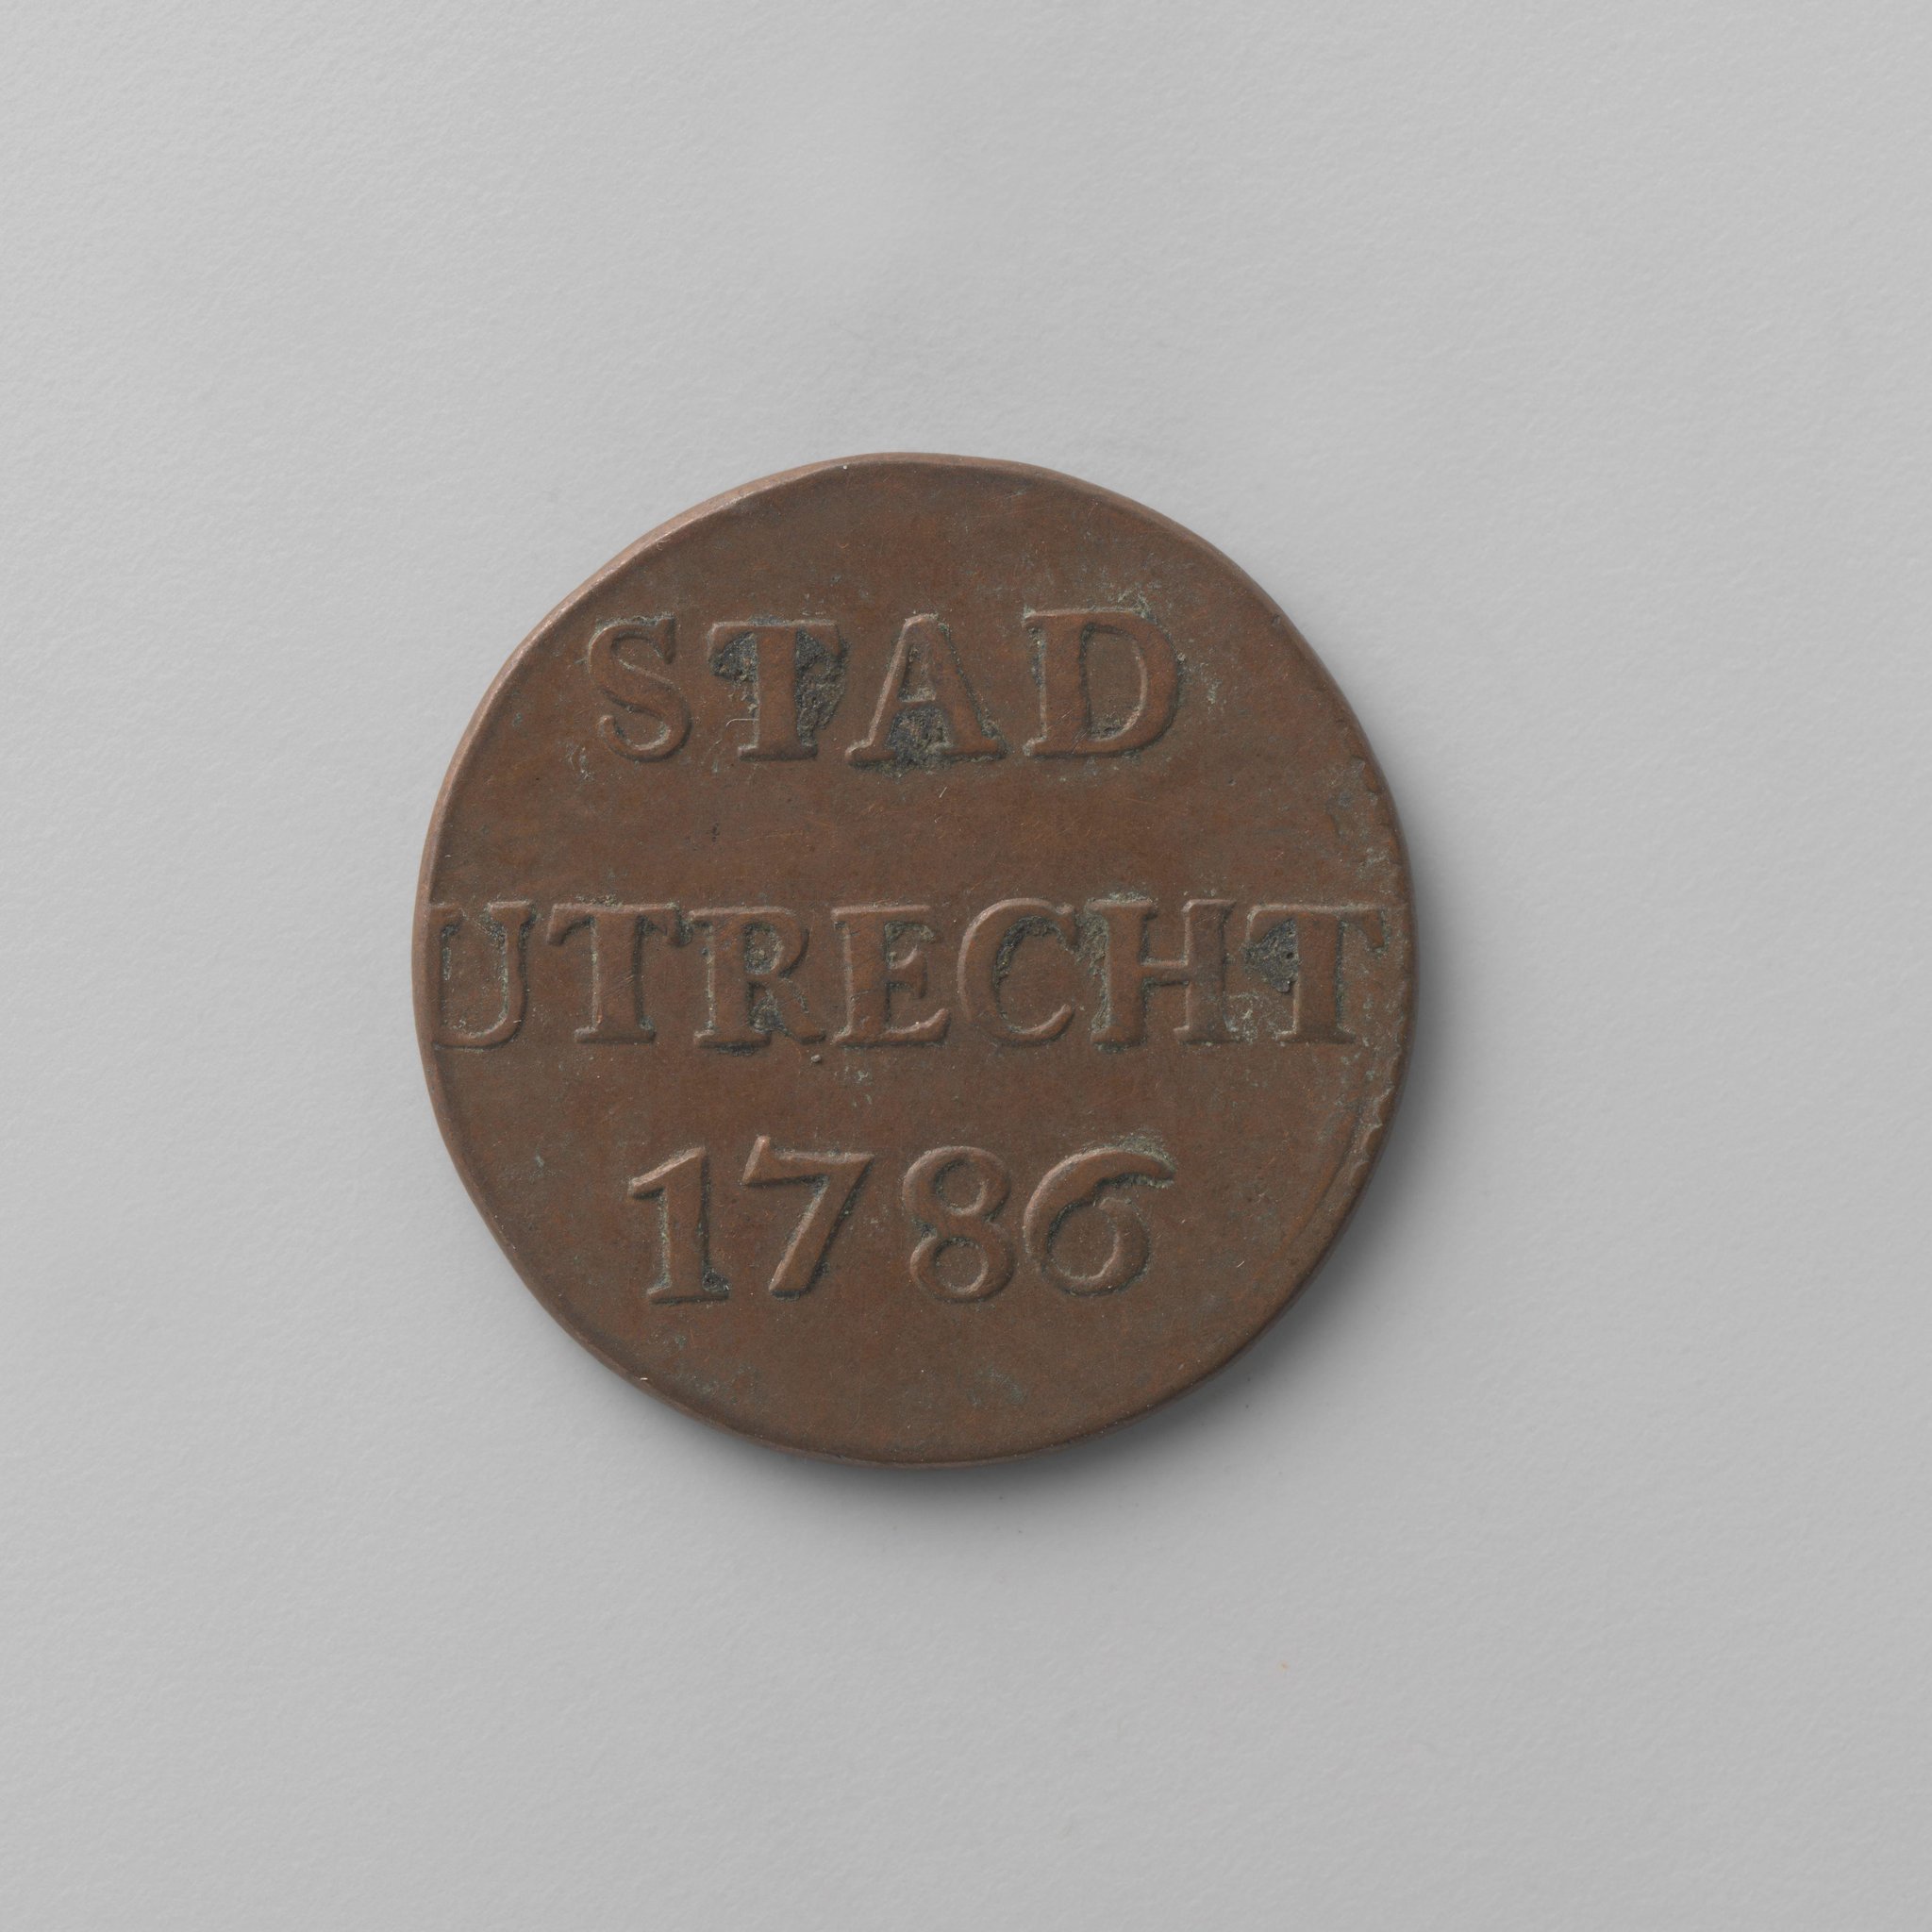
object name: coin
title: Stad Utrecht, duit, 1786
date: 1786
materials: copper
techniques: striking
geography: utrecht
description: Koperen munt. Voorzijde: gekroond stedelijk wapenschild, gehouden door twee leeuwen met in afsnede dubbele lijn, waaronder een versierde accolade met een grote schelp. Keerzijde: opschrift in twee regels, waaronder jaartal. Jaartal met Arabische 1.